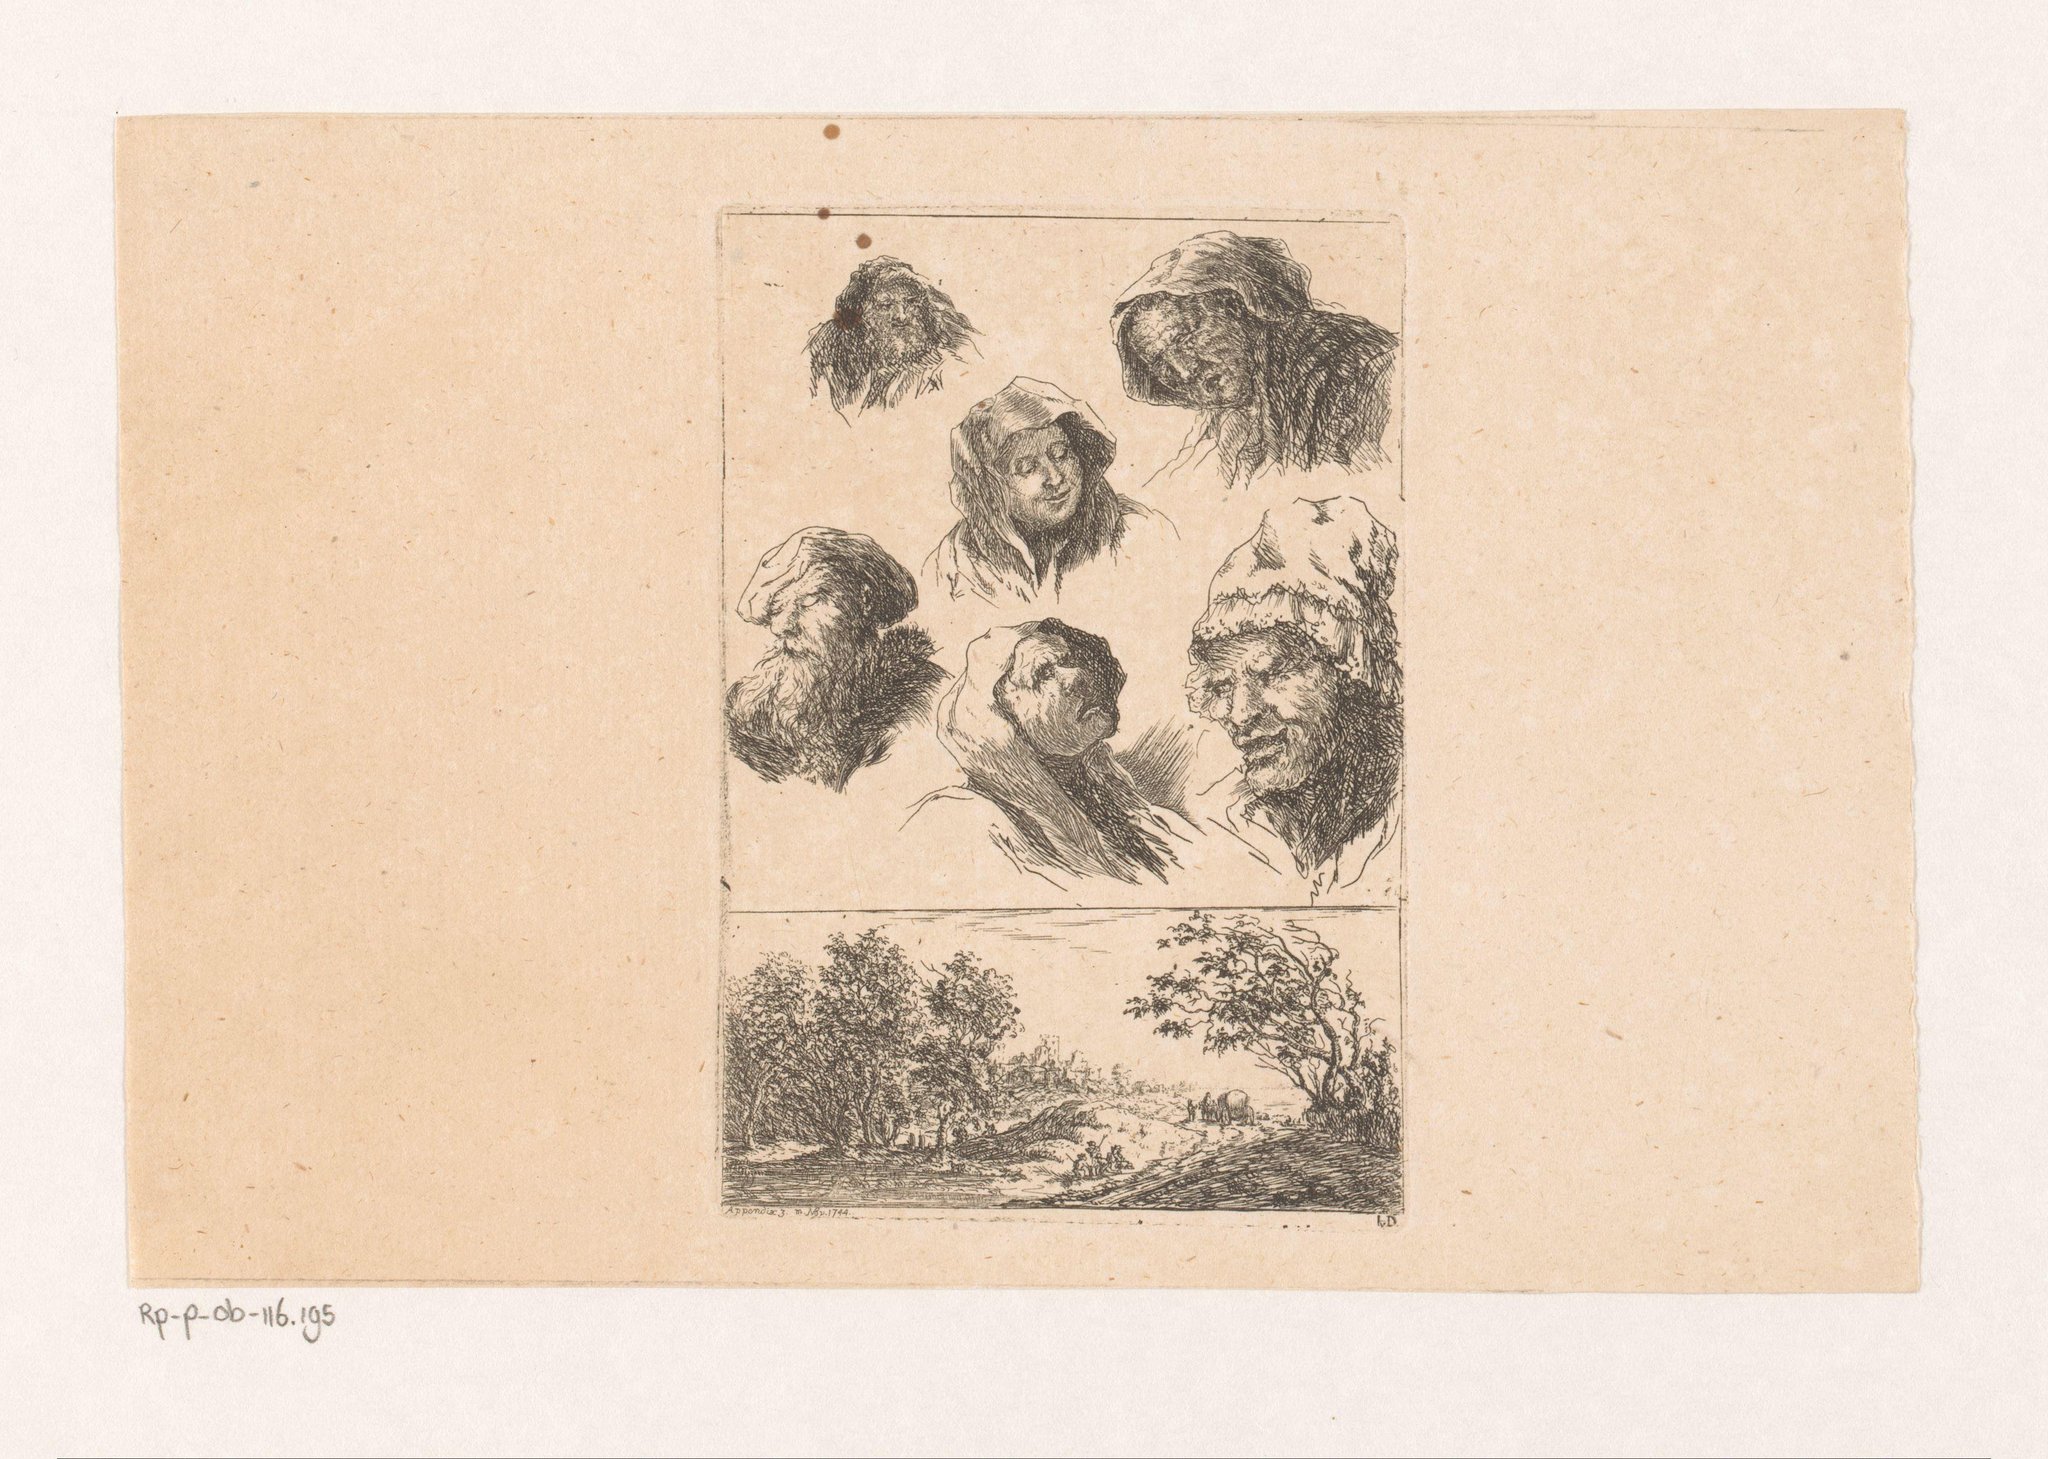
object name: print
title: Zes mannen- en vrouwenkoppen en een landschap met dorp in de verte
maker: christian ludwig von hagedorn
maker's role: painter, print maker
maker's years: 1712-1780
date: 1711-1744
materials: paper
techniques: etching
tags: head (human), city-view, and landscape with man-made constructions (+ city(-scape) with figures, staffage)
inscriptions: collector's mark: Lugt 240